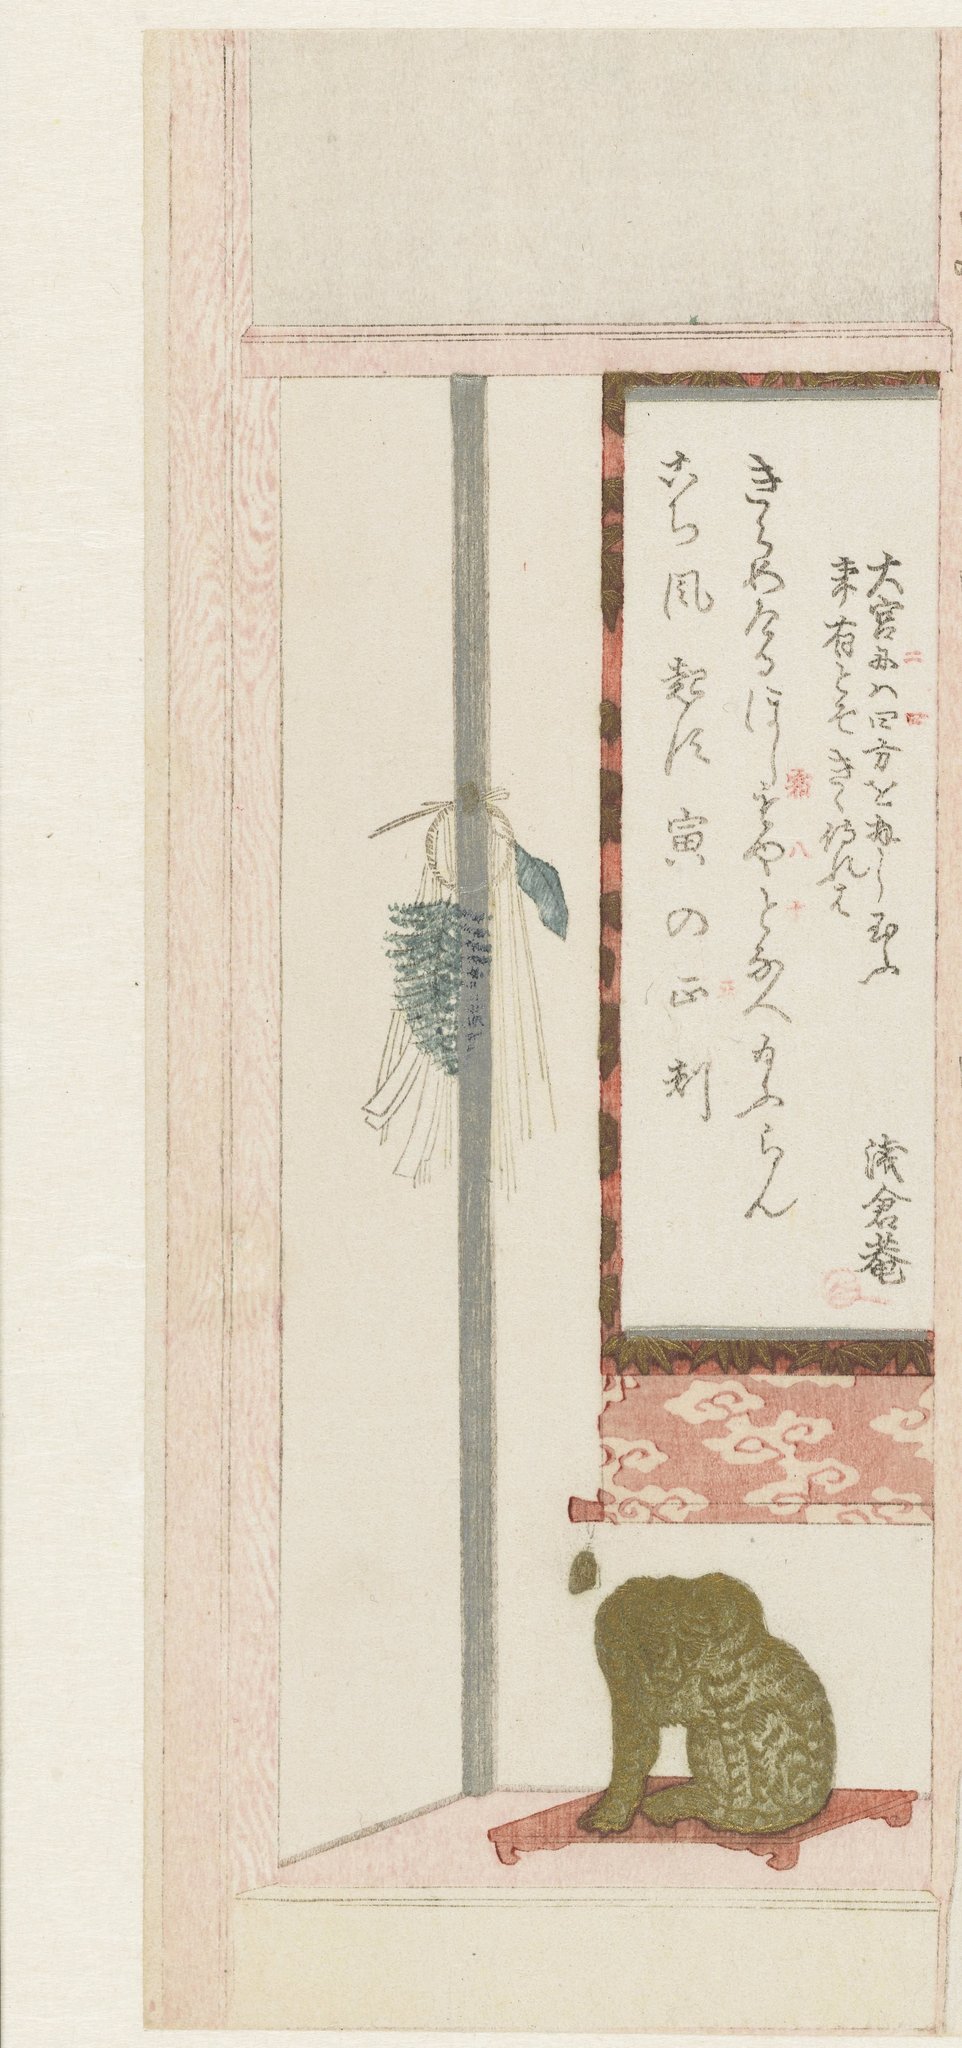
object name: egoyomi kalenderblad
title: New Year's Arrangement with a Tiger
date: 1806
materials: paper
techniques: blind stamped, woodcut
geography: japan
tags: beasts of prey, predatory animals: tiger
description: Een surimono is een luxe uitgevoerde prent waarop beeld met één of meerdere gedichten gecombineerd is. Bij het drukken van een surimono werd vaak gebruik gemaakt van dikker papier, blinddruk en metaal pigmenten, zoals koper- en zilverpoeder. De prenten werden vaak in opdracht van dichters gemaakt en als exclusief geschenk aan vrienden en relaties gegeven. Een egoyomi is een kalender prent, waarop de aanduiding voor de maanden verstopt zit in het ontwerp. Vaak werden egoyomi net als surimono in eigen beheer uitgegeven en aan vrienden kado gedaan. In Japan gebruikte men tot 1873 een maankalender, waarbij de volgorde van de lange en de korte maanden jaarlijks varieerde. Omdat er maar een klein aantal uitgevers kalenders mocht maken, waren particulier uitgeven kalender prenten tegen de regels van de overheid. Om deze regels te omzeilen werden de kalendergegevens verstopt in het prentontwerp.